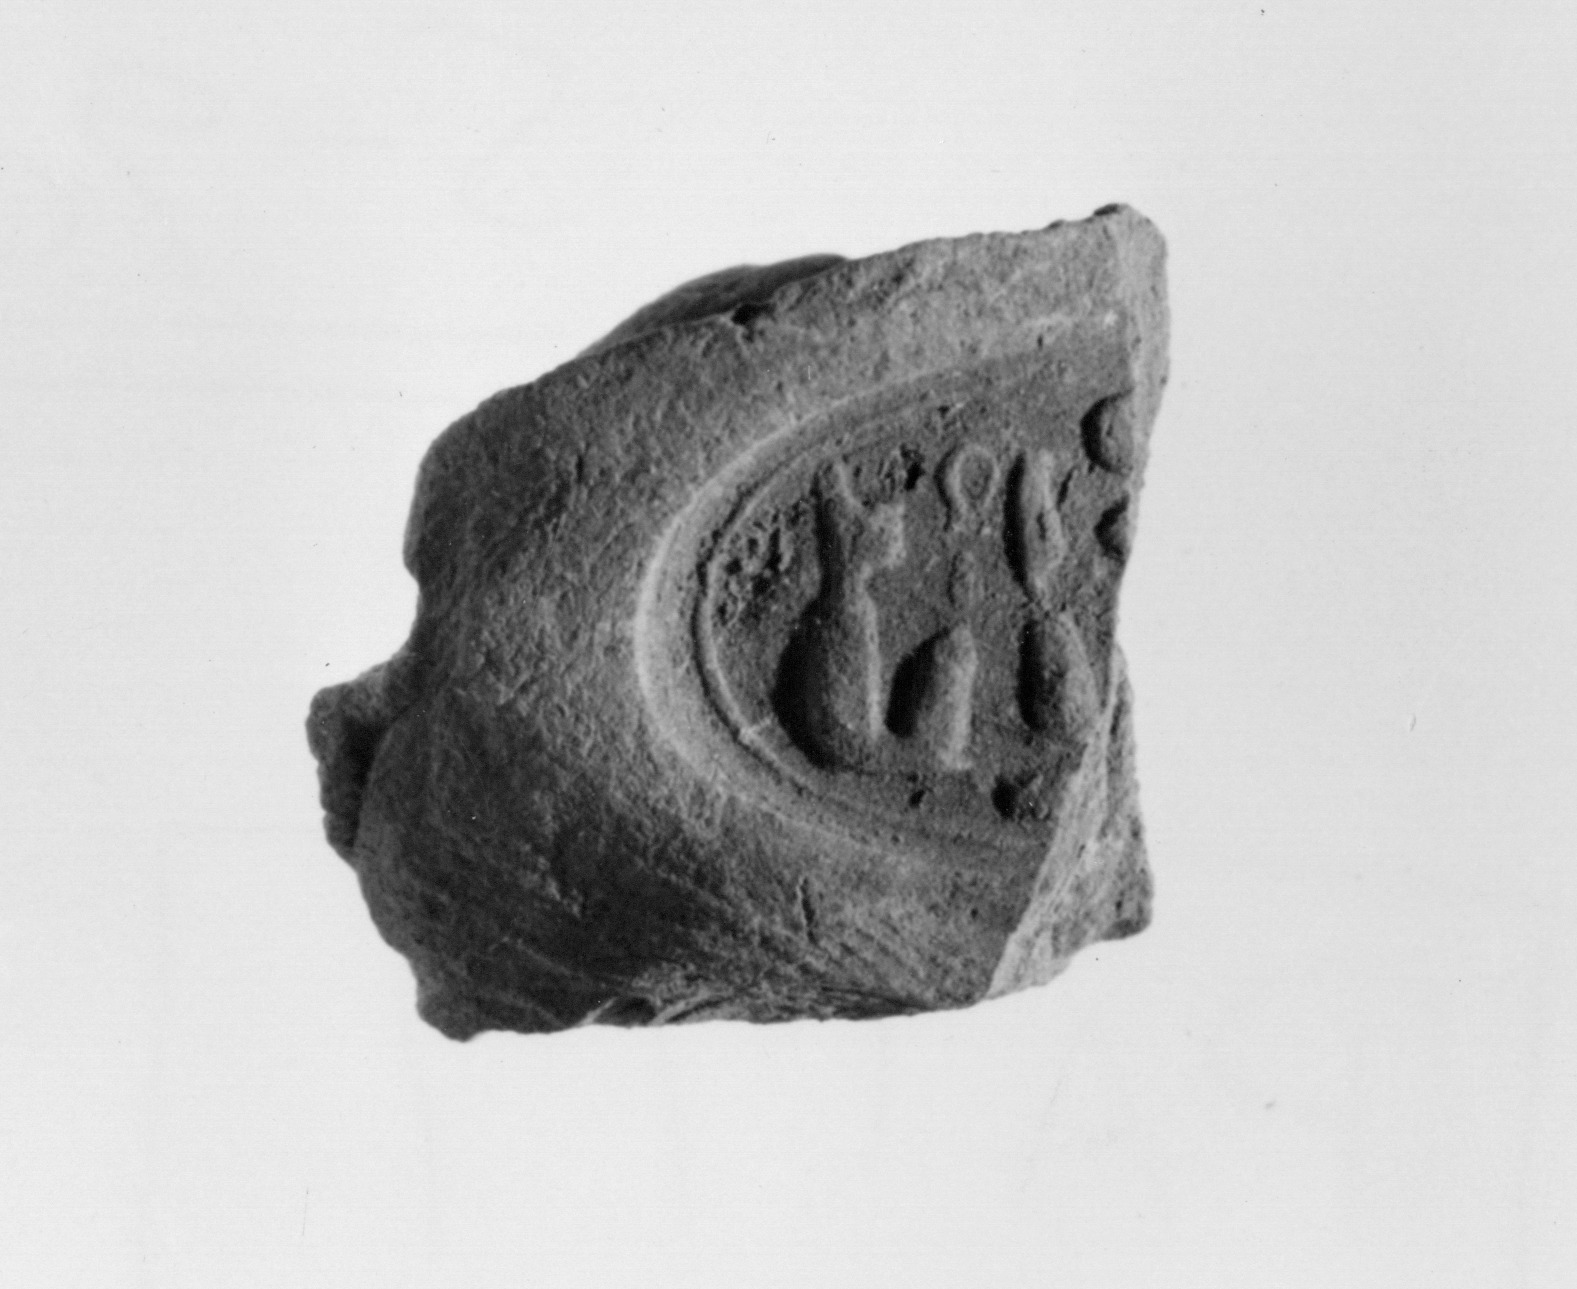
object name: sealing, nebmaatre, red crown, amenhotep iii, nut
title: Document Sealing With the Throne Name of Amenhotep III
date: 1390-1352 BCE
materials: mud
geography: egypt